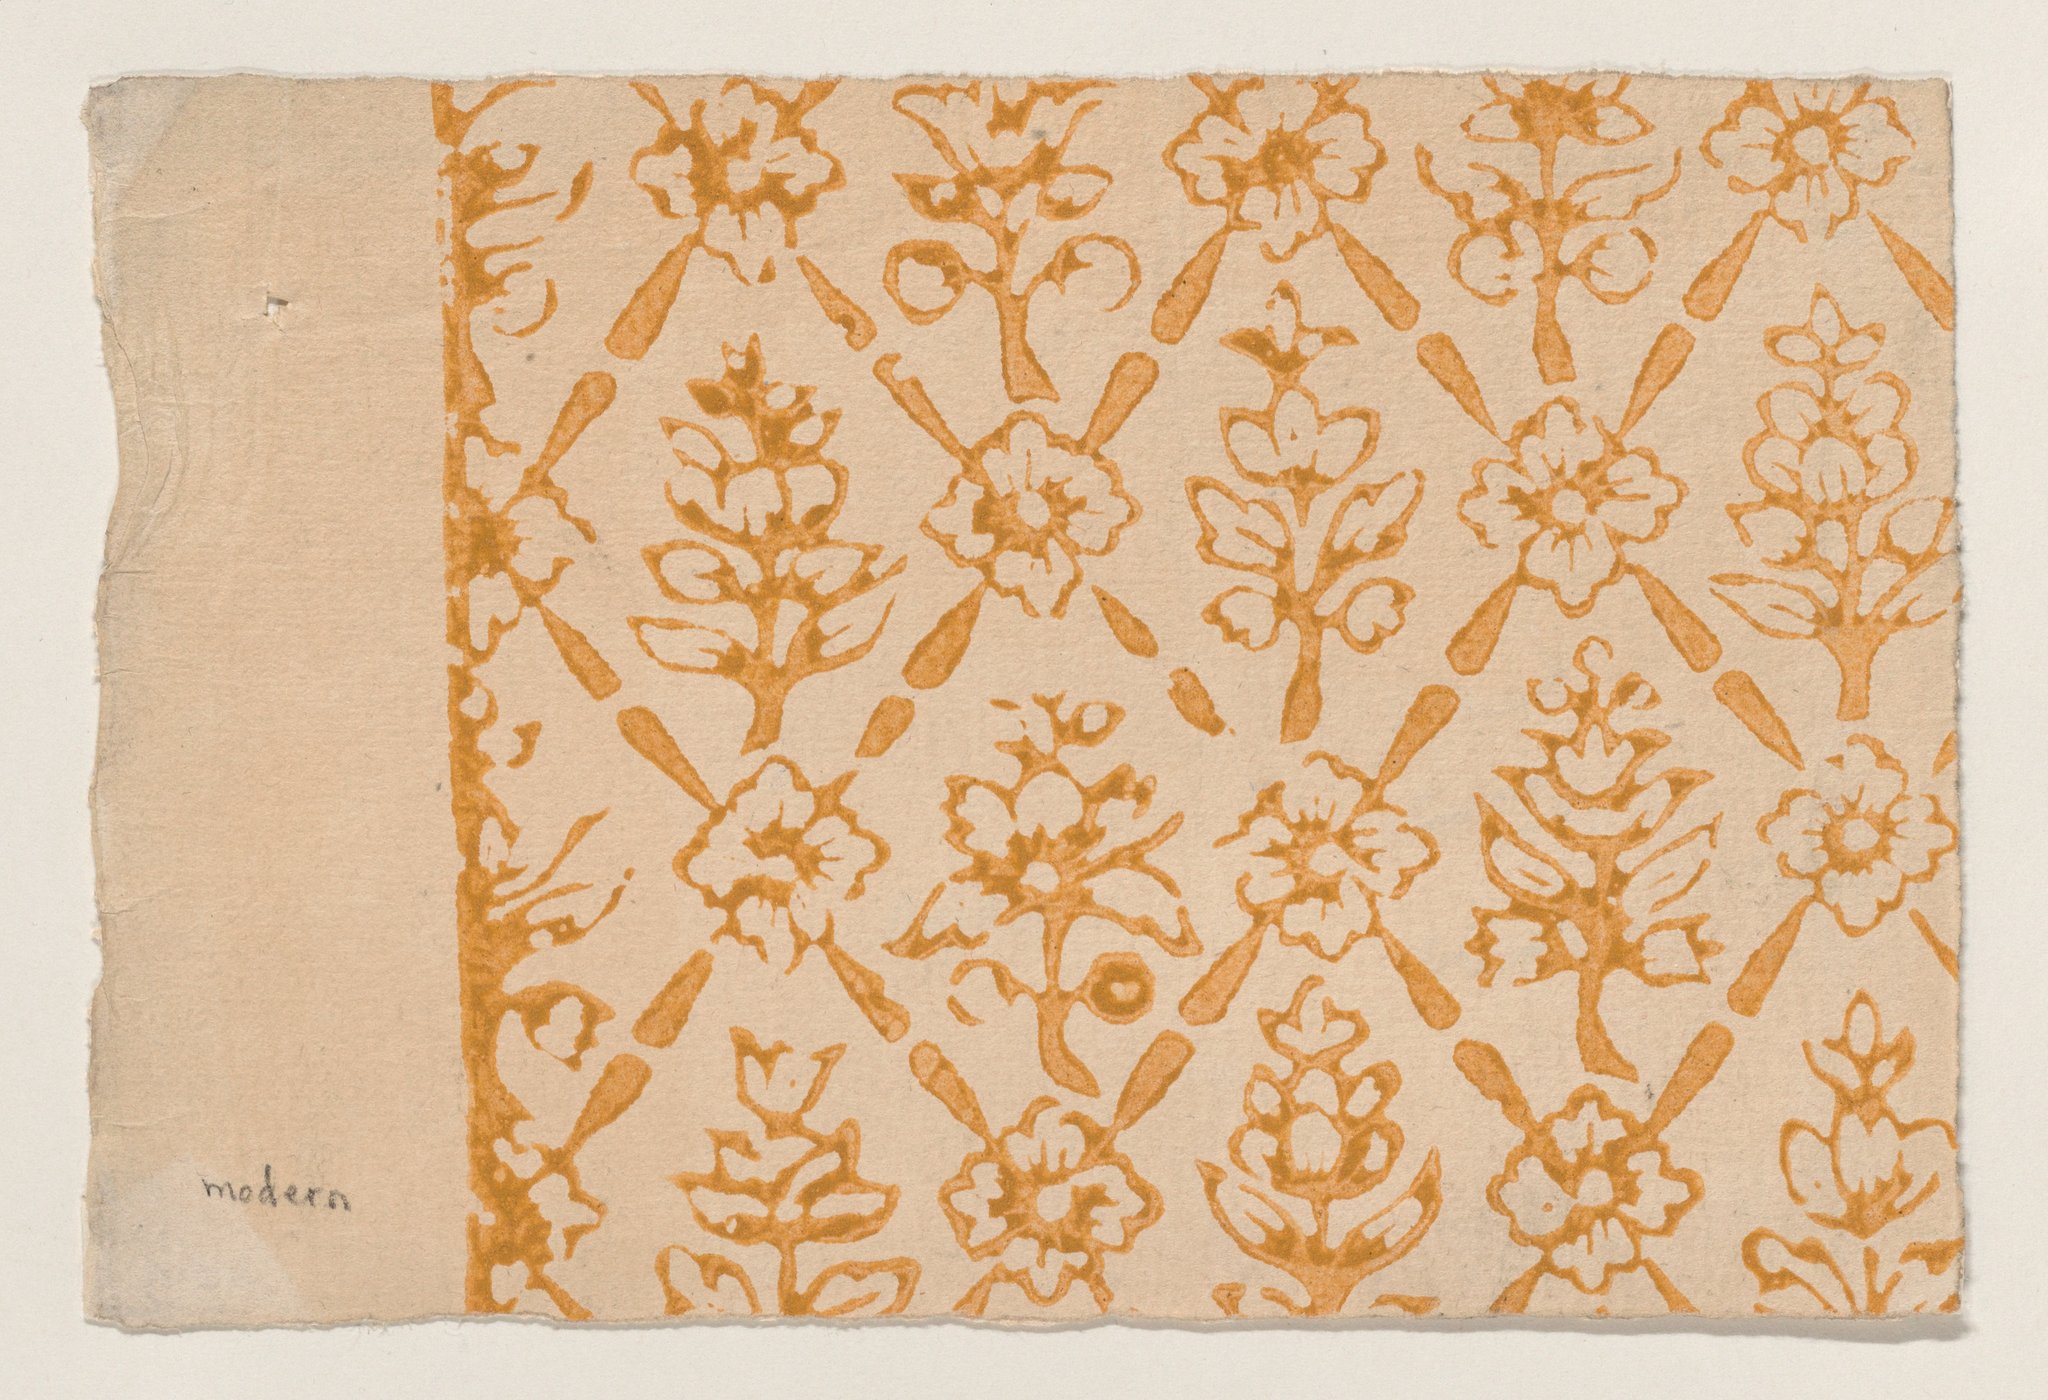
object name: print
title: Sheet with overall floral pattern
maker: Anonymous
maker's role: artist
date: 1801-1900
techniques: relief print